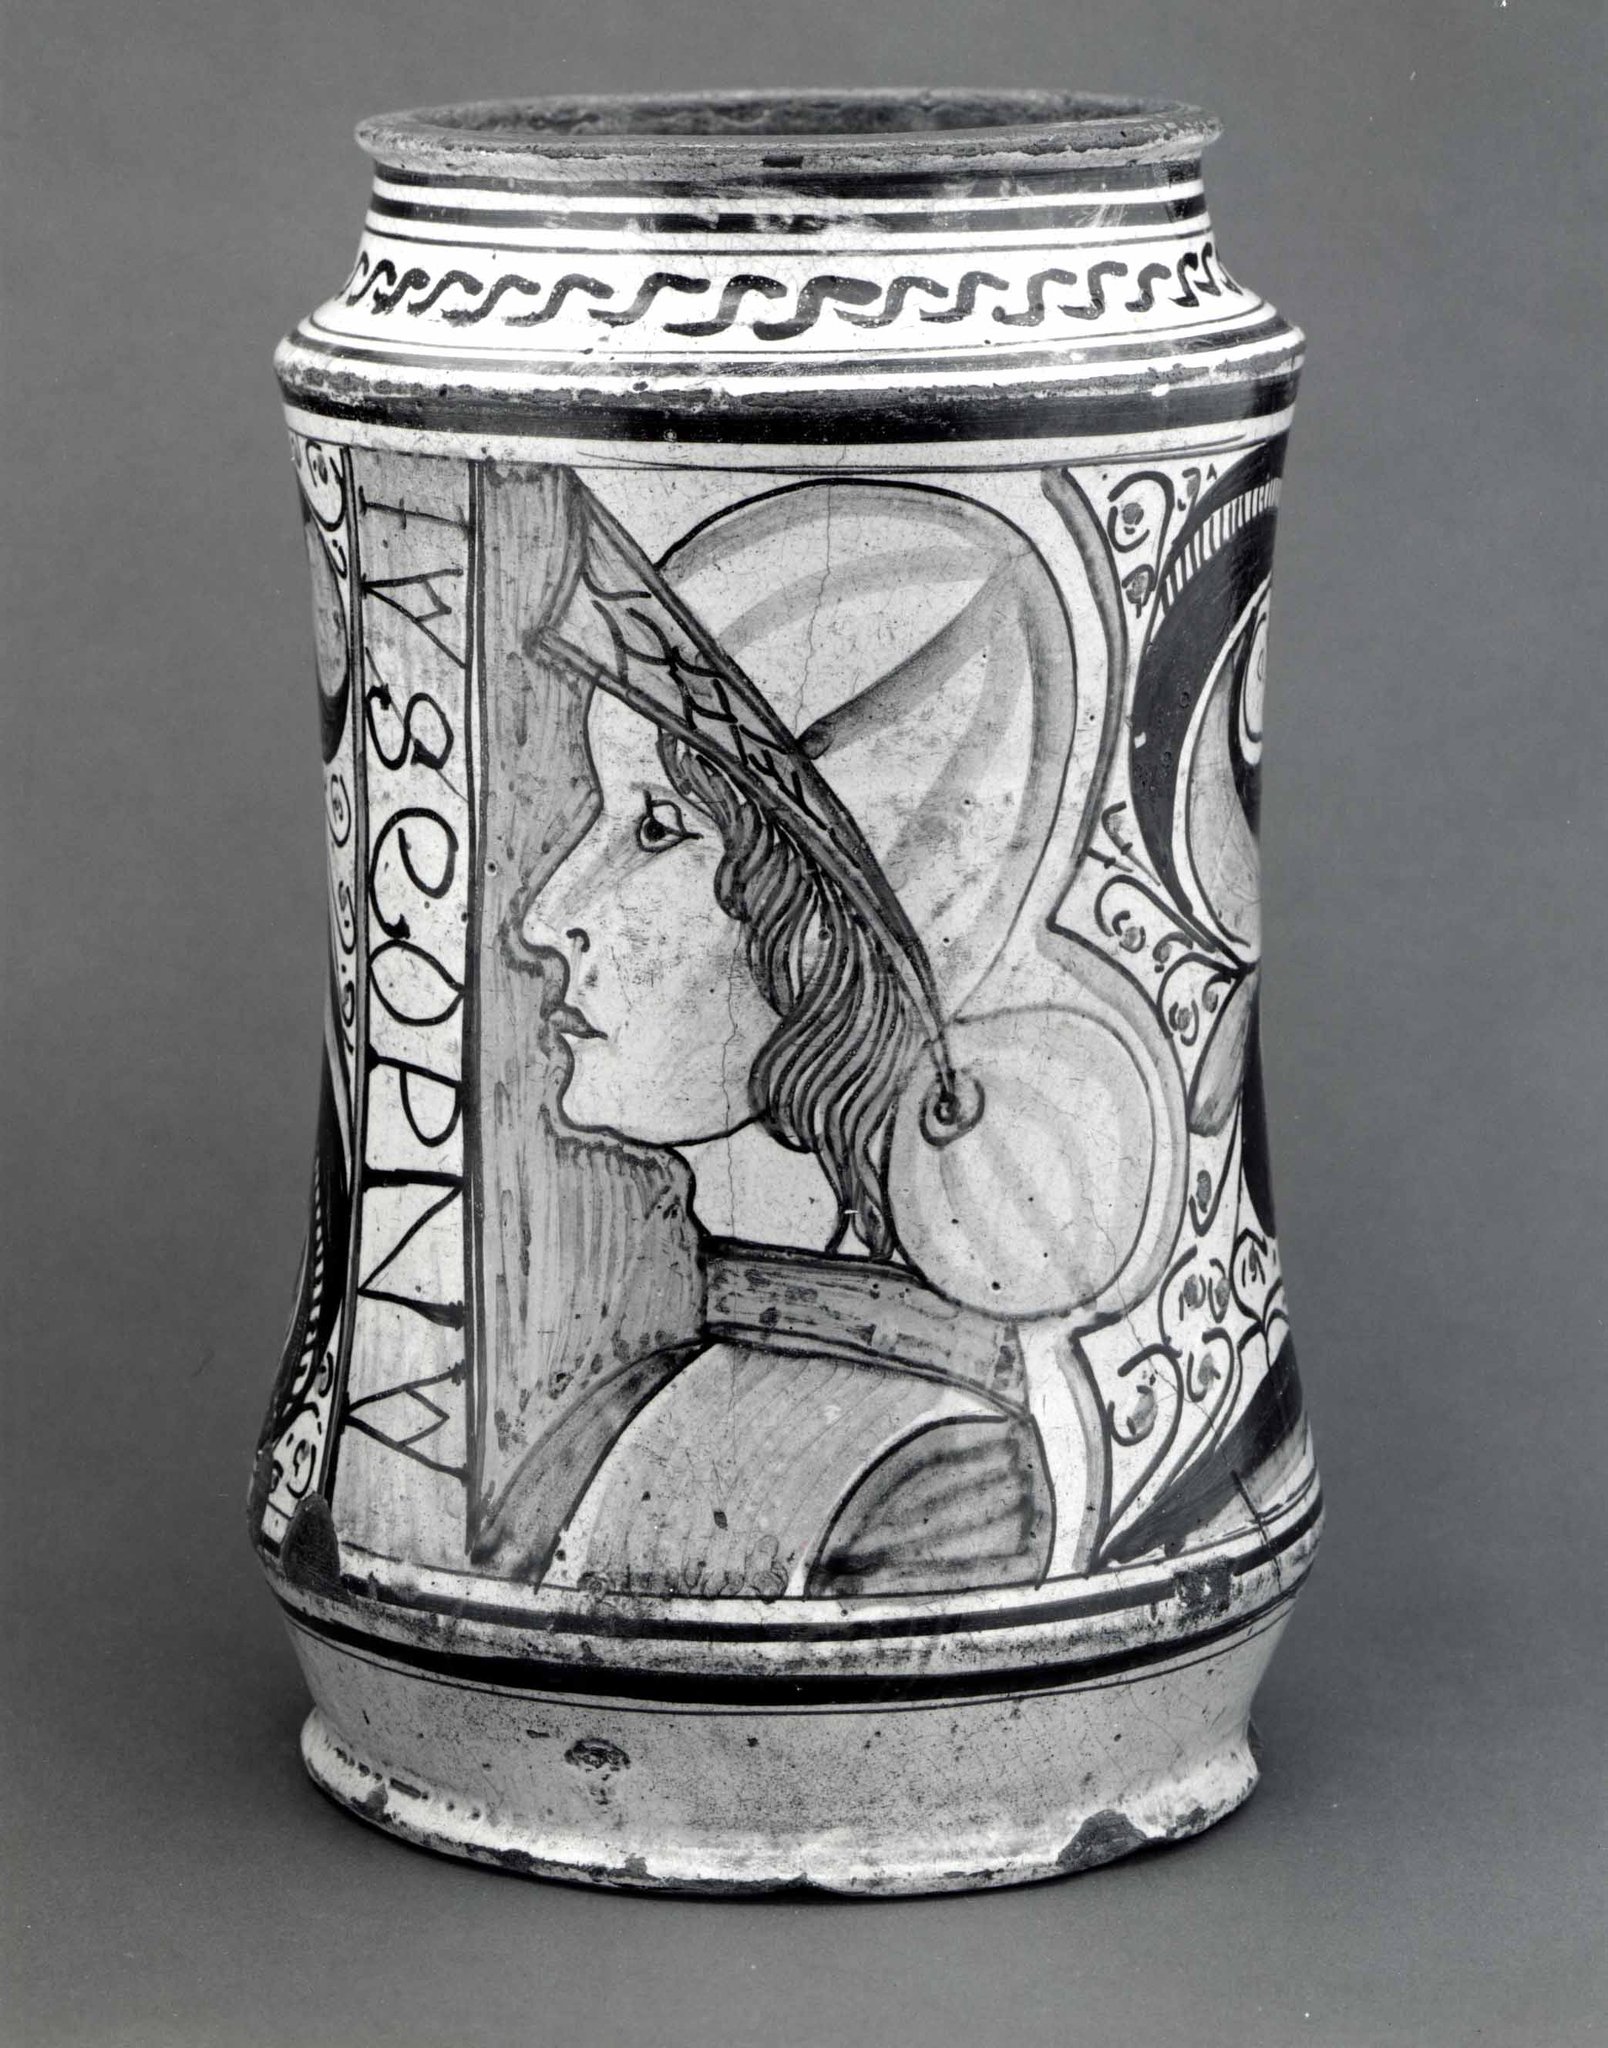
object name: albarello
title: Maiolica: Apothecary jar (albarello)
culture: italian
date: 1467-1500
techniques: maiolica, glazing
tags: men,profiles